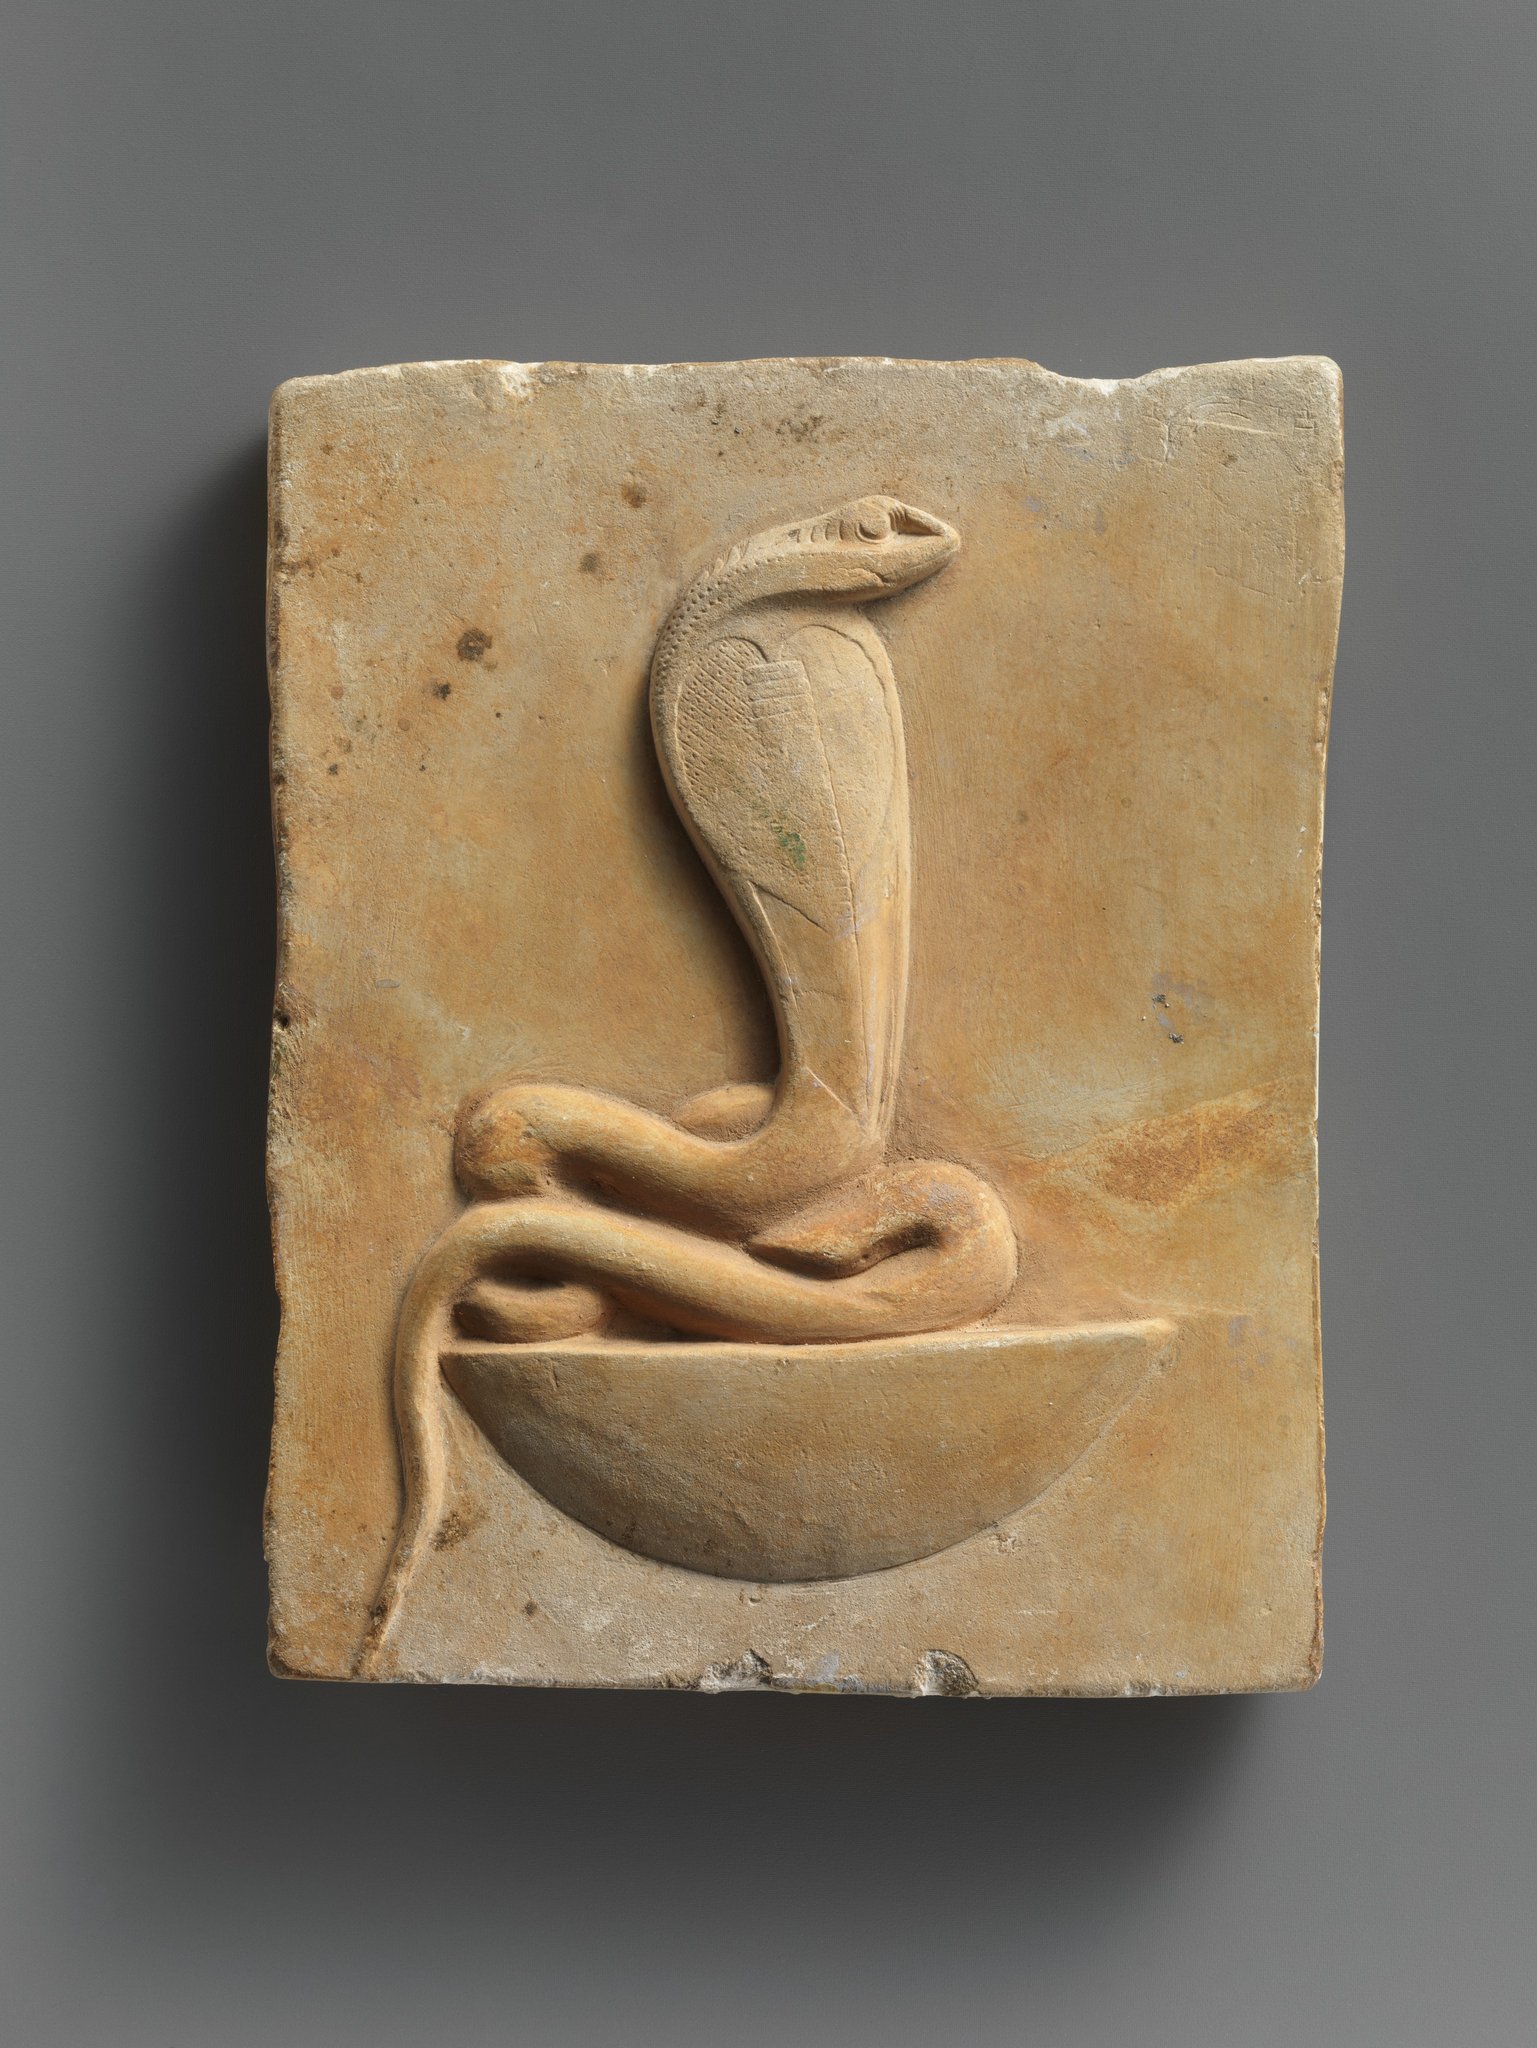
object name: sculptor's model votive, uraeus cobra on neb basket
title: Relief plaque of cobra on a neb basket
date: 400-30 BCE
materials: limestone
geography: egypt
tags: snakes